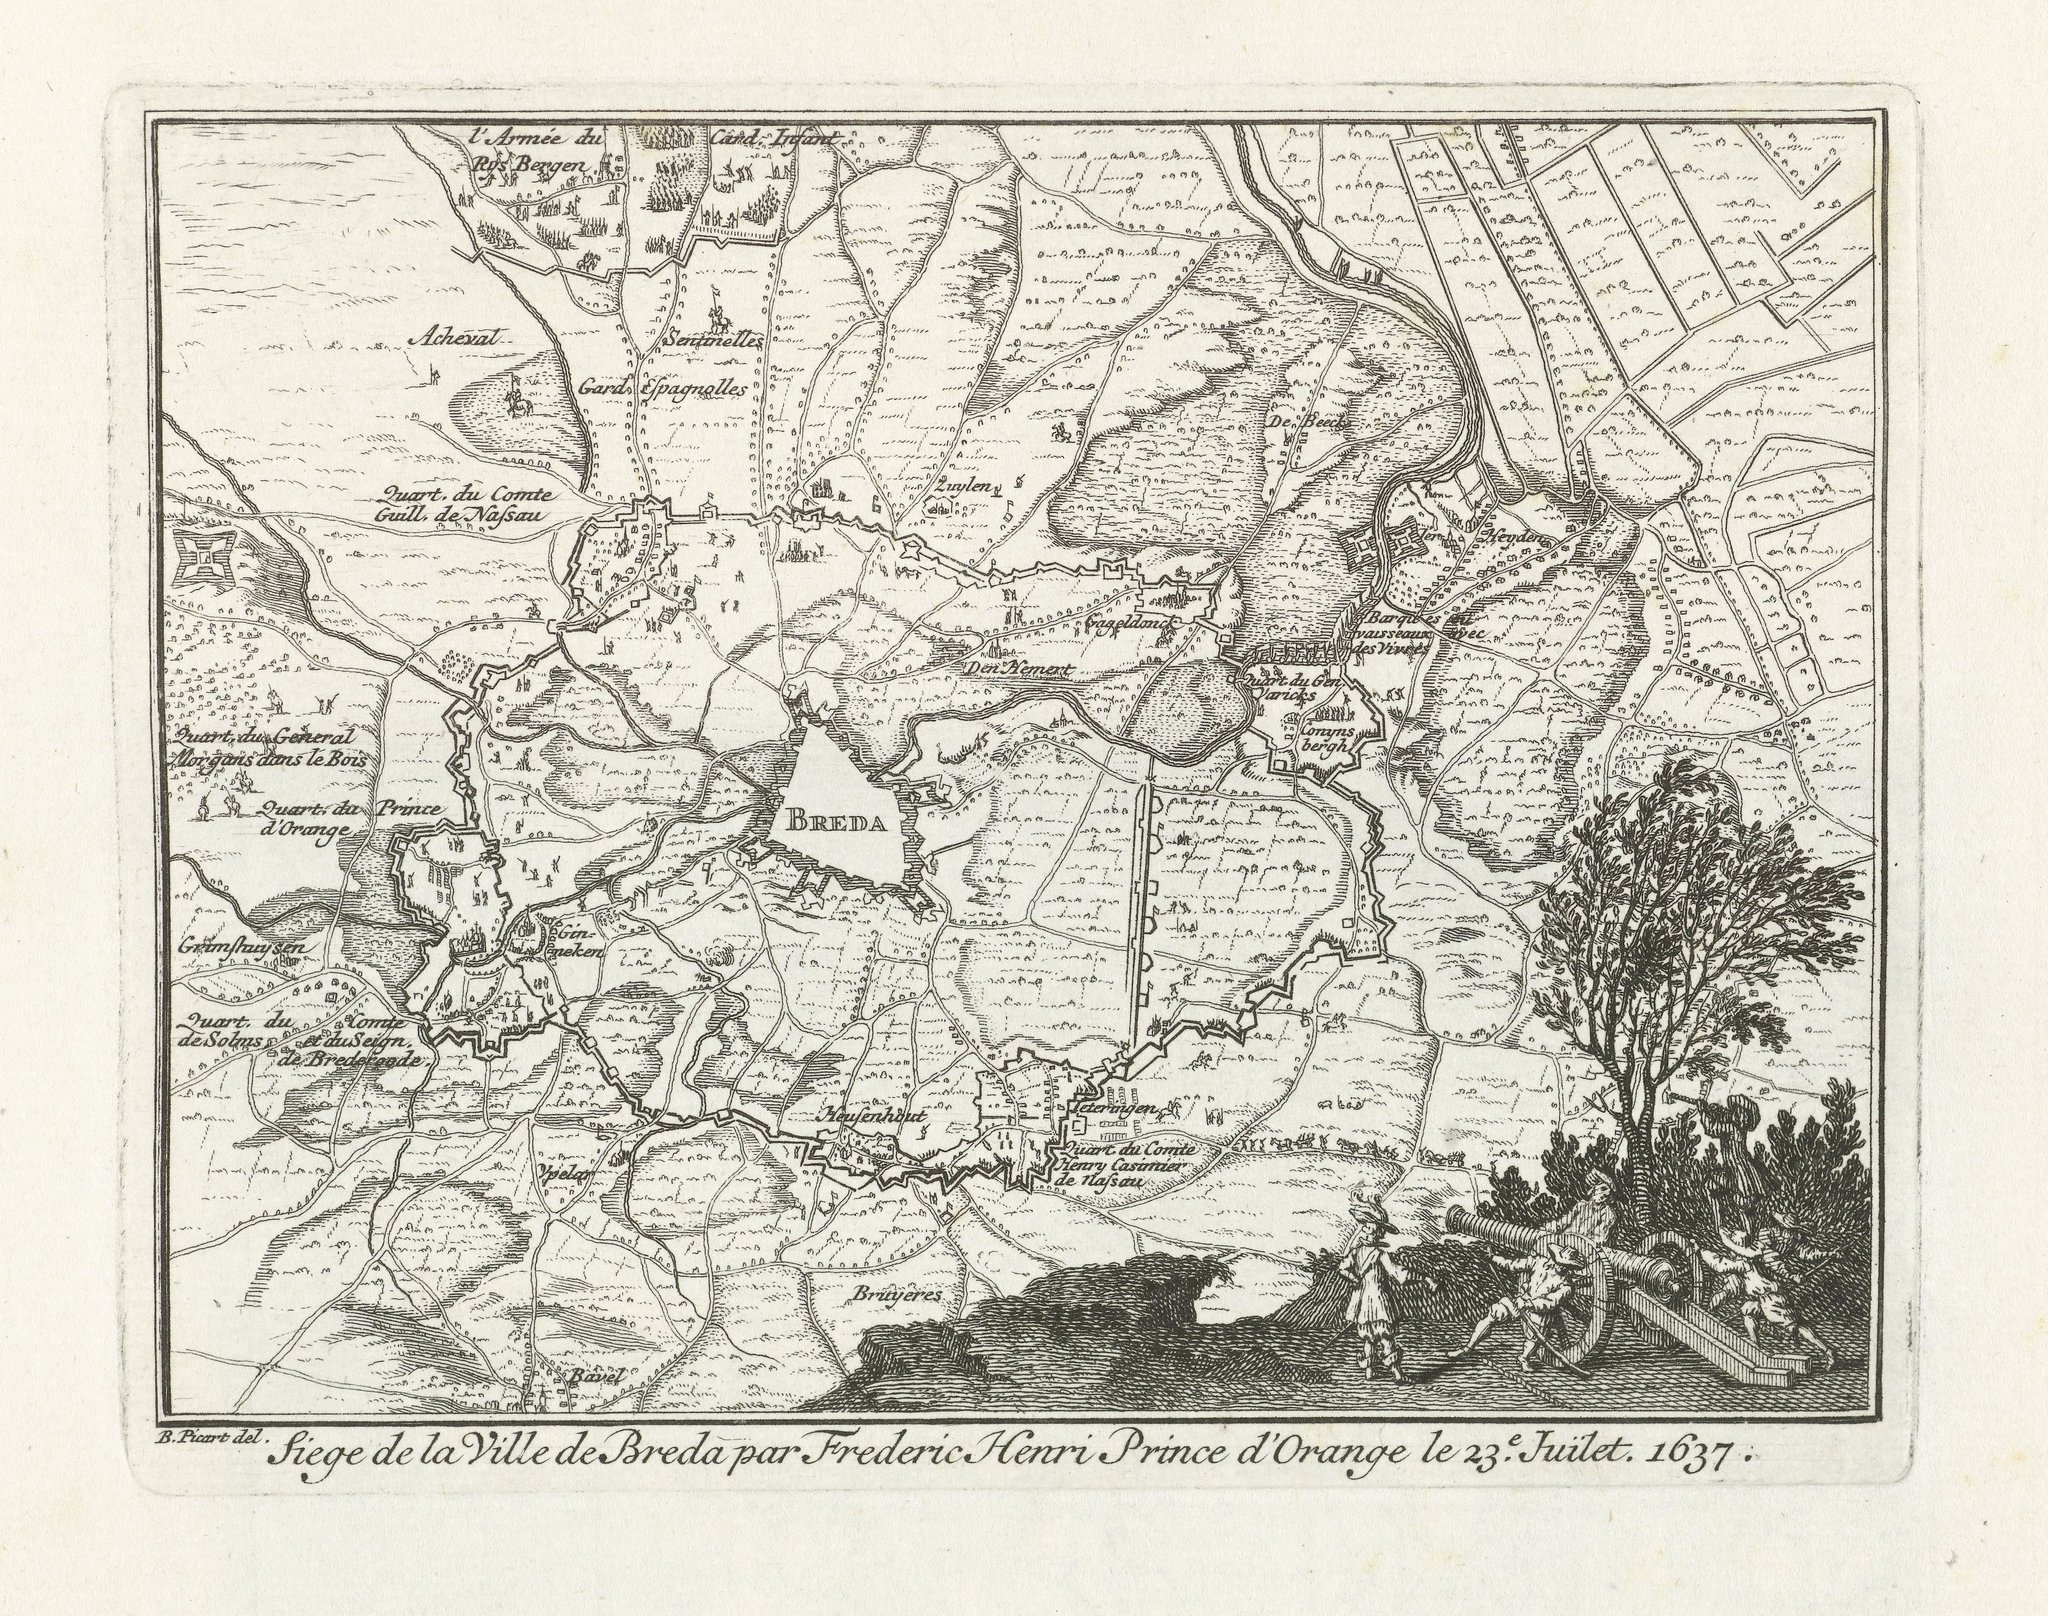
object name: history print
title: Siege de la Ville de Breda par Frederic Henri Prince d'Orange le 23e. Juilet 1637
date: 1732-1733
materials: paper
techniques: etching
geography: northern netherlands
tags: delft, the hague, frederick henry (prince of orange), maps of separate countries or regions, siege, position war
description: Kaart van Breda en het omliggende land gedurende de omsingeling en het beleg door het Staatse leger onder Frederik Hendrik, 23 juli - 10 oktober 1637. Op de voorgrond soldaten bij een kanon. Deze plaat samen met een andere plaat op één bladzijde gedrukt.